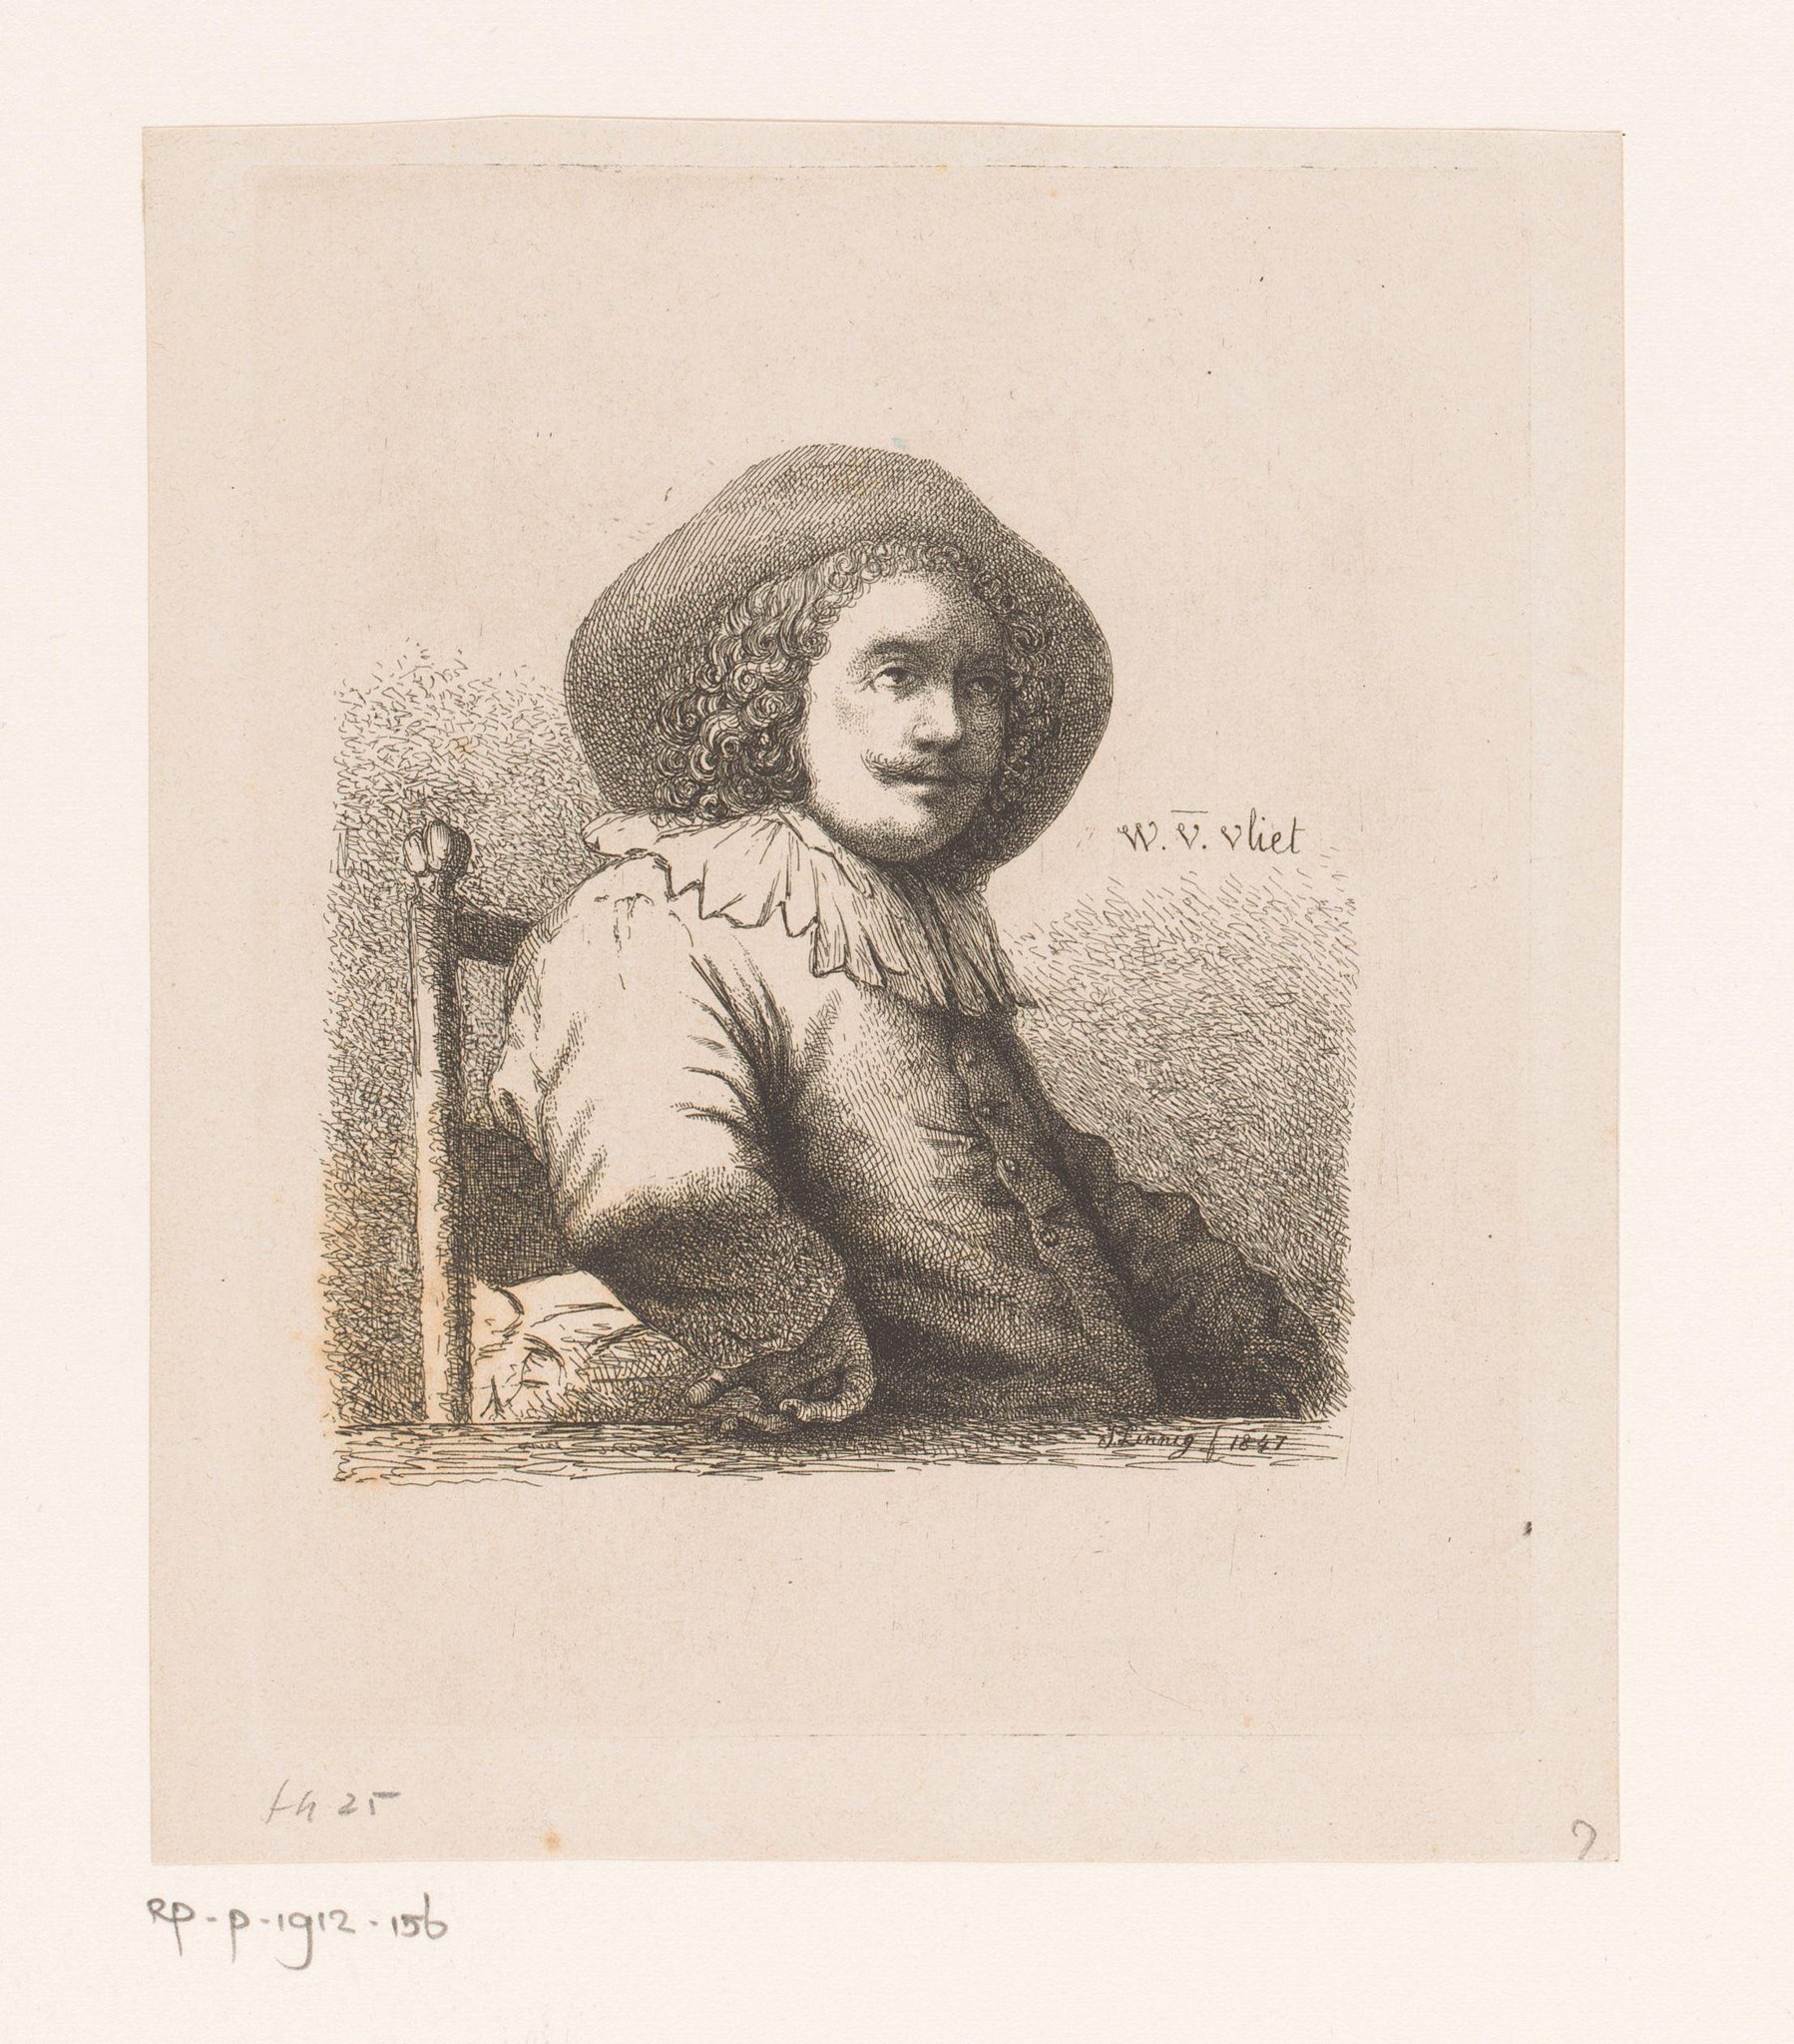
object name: print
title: Portret van een onbekende man op een stoel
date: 1847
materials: paper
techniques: etching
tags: anonymous historical person portrayed alone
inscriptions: collector's mark: Lugt 2228, collector's mark: Lugt 1485